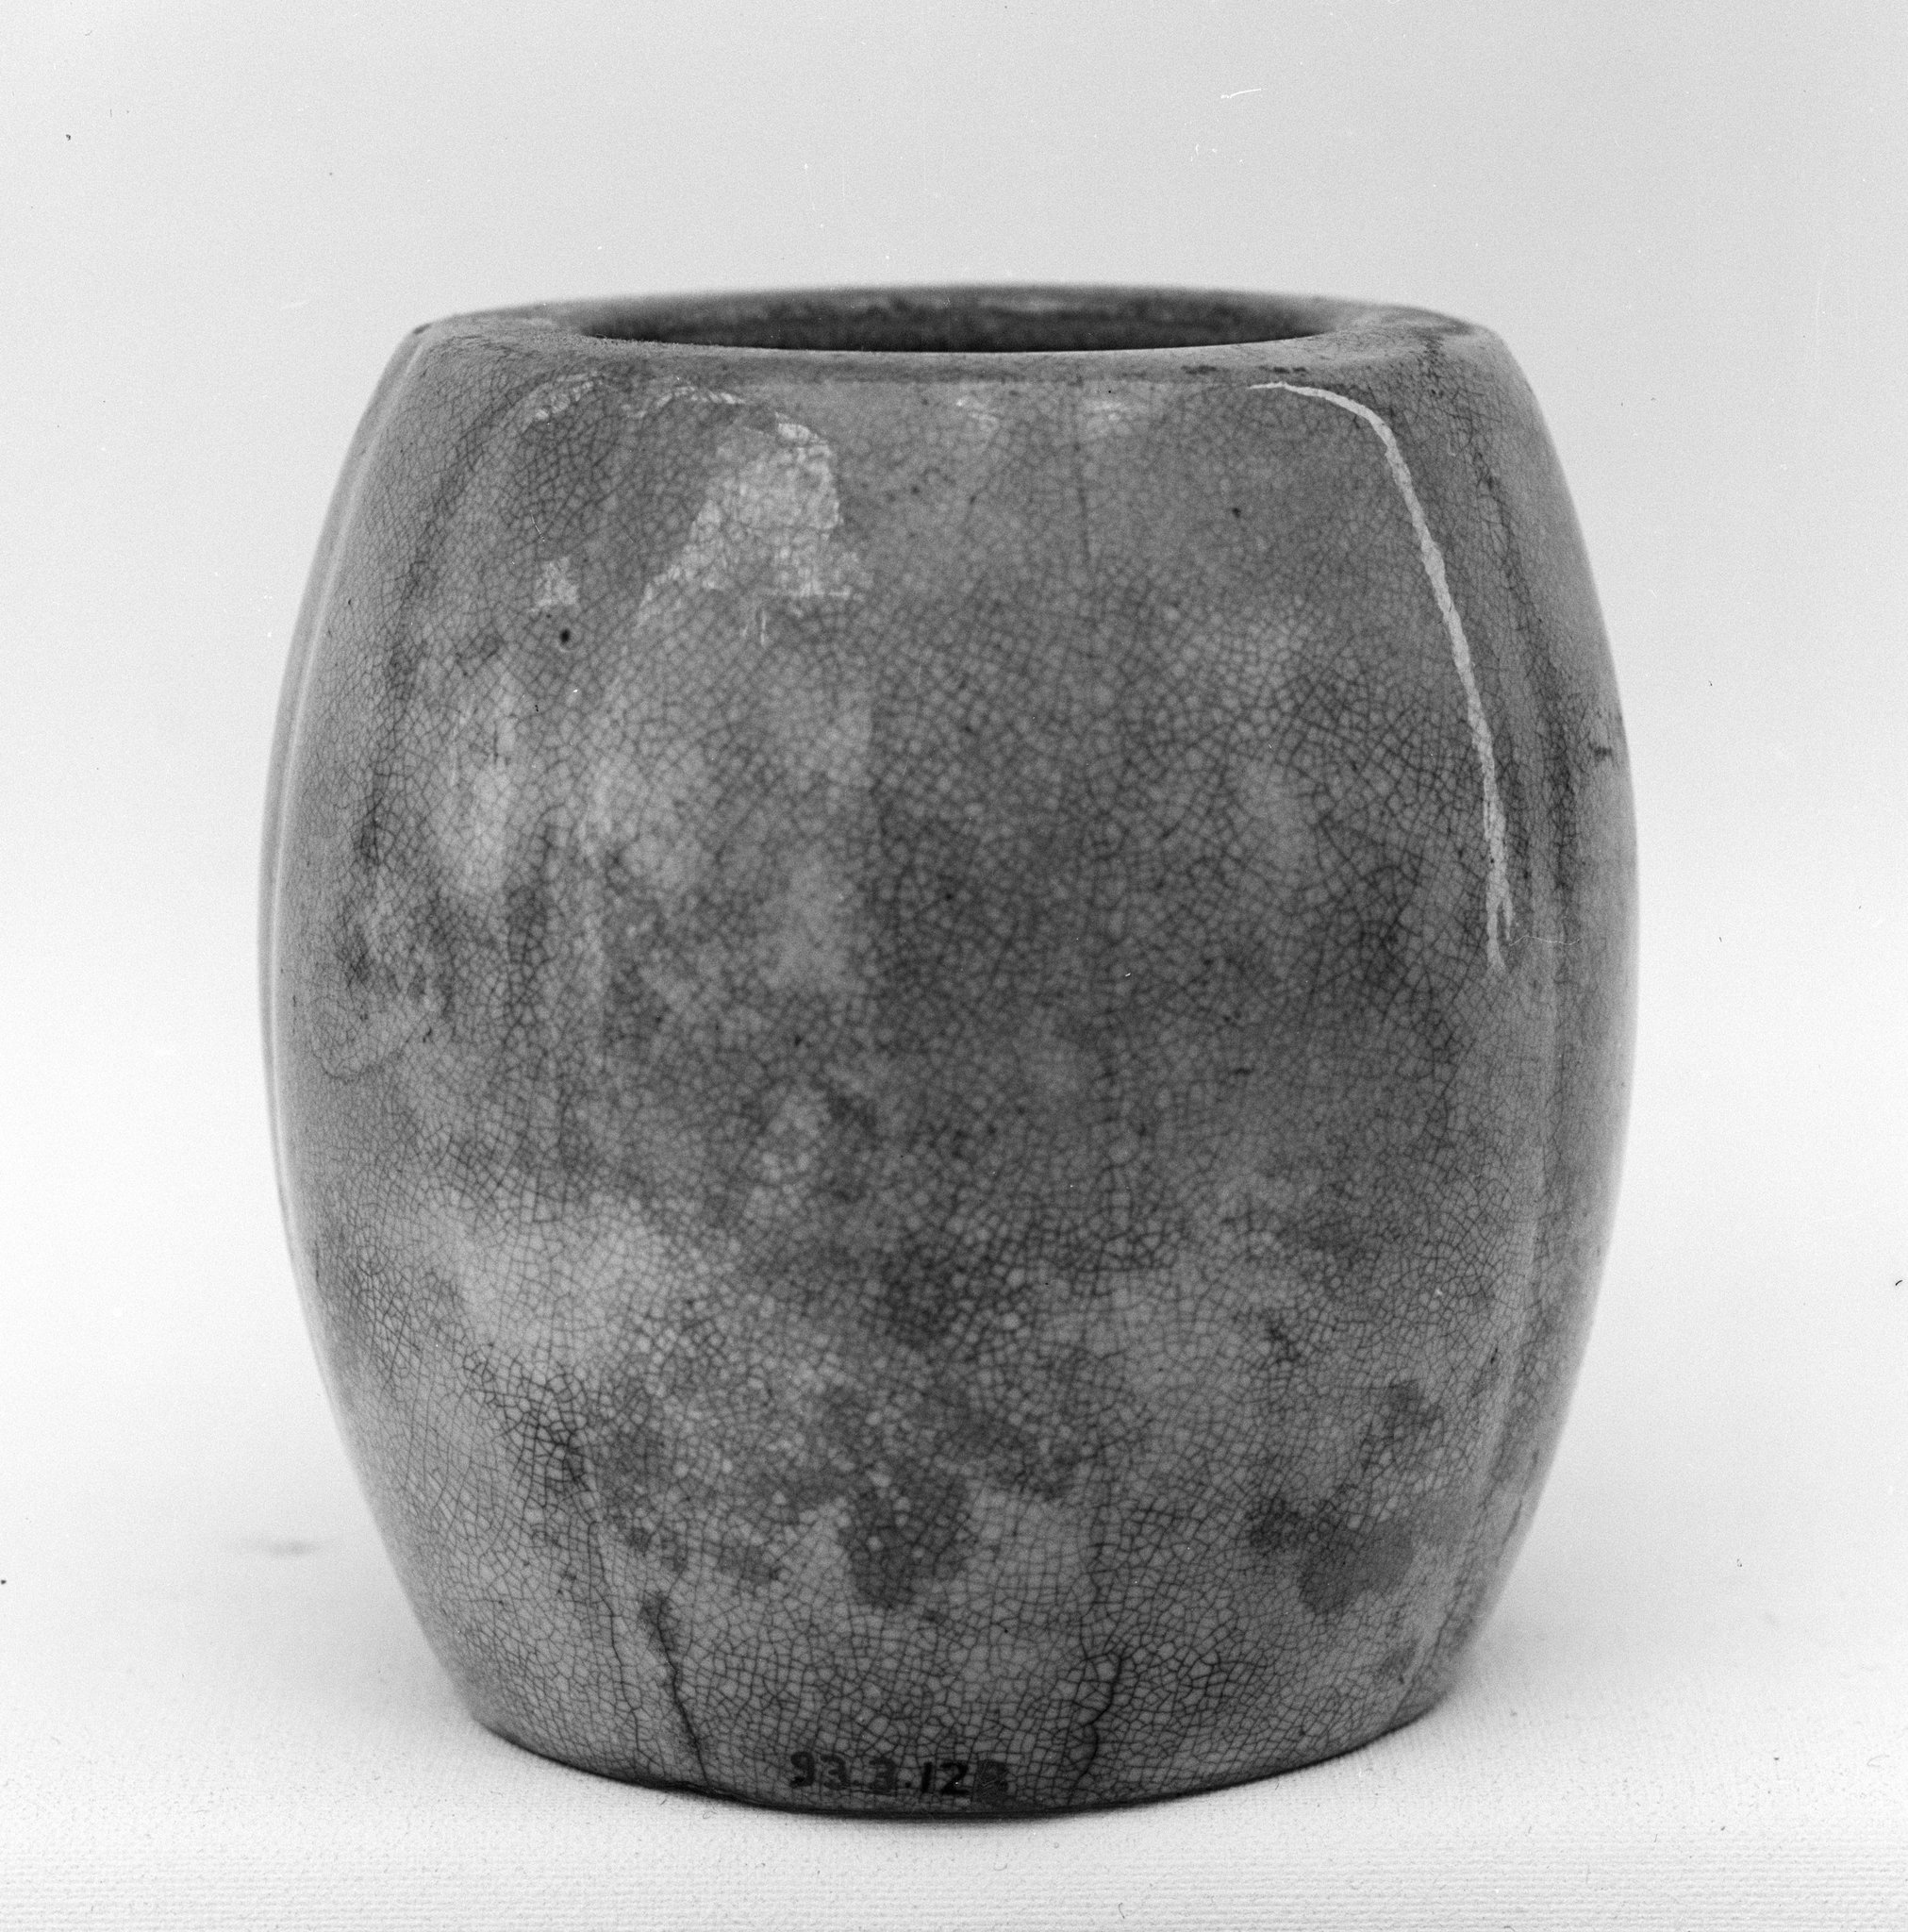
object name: incense burner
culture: japanese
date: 1620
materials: clay, glaze